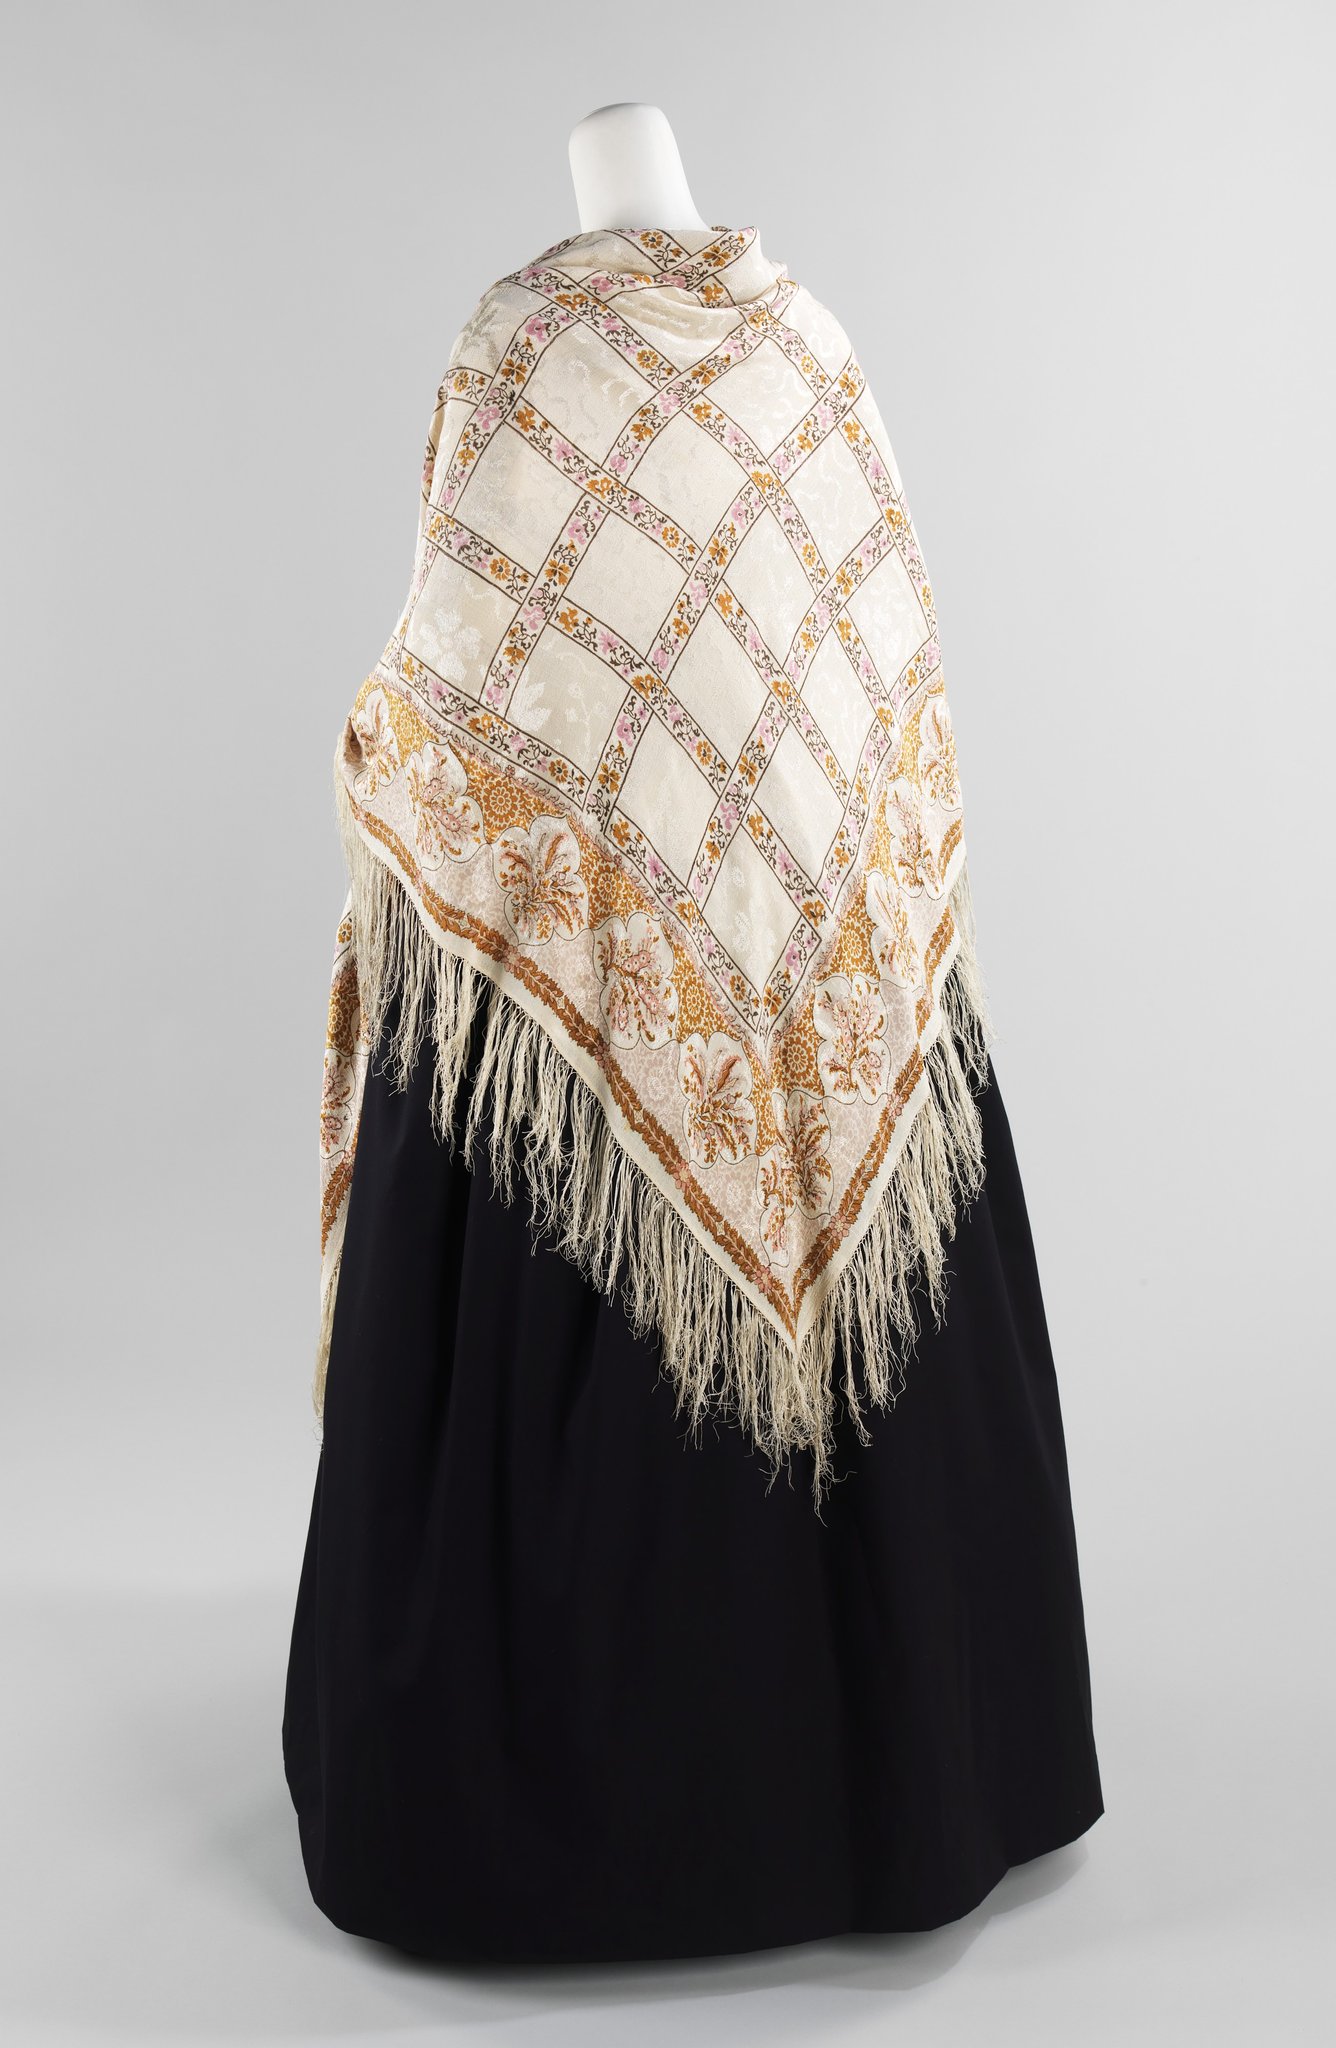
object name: shawl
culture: french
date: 1840-1849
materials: silk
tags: flowers